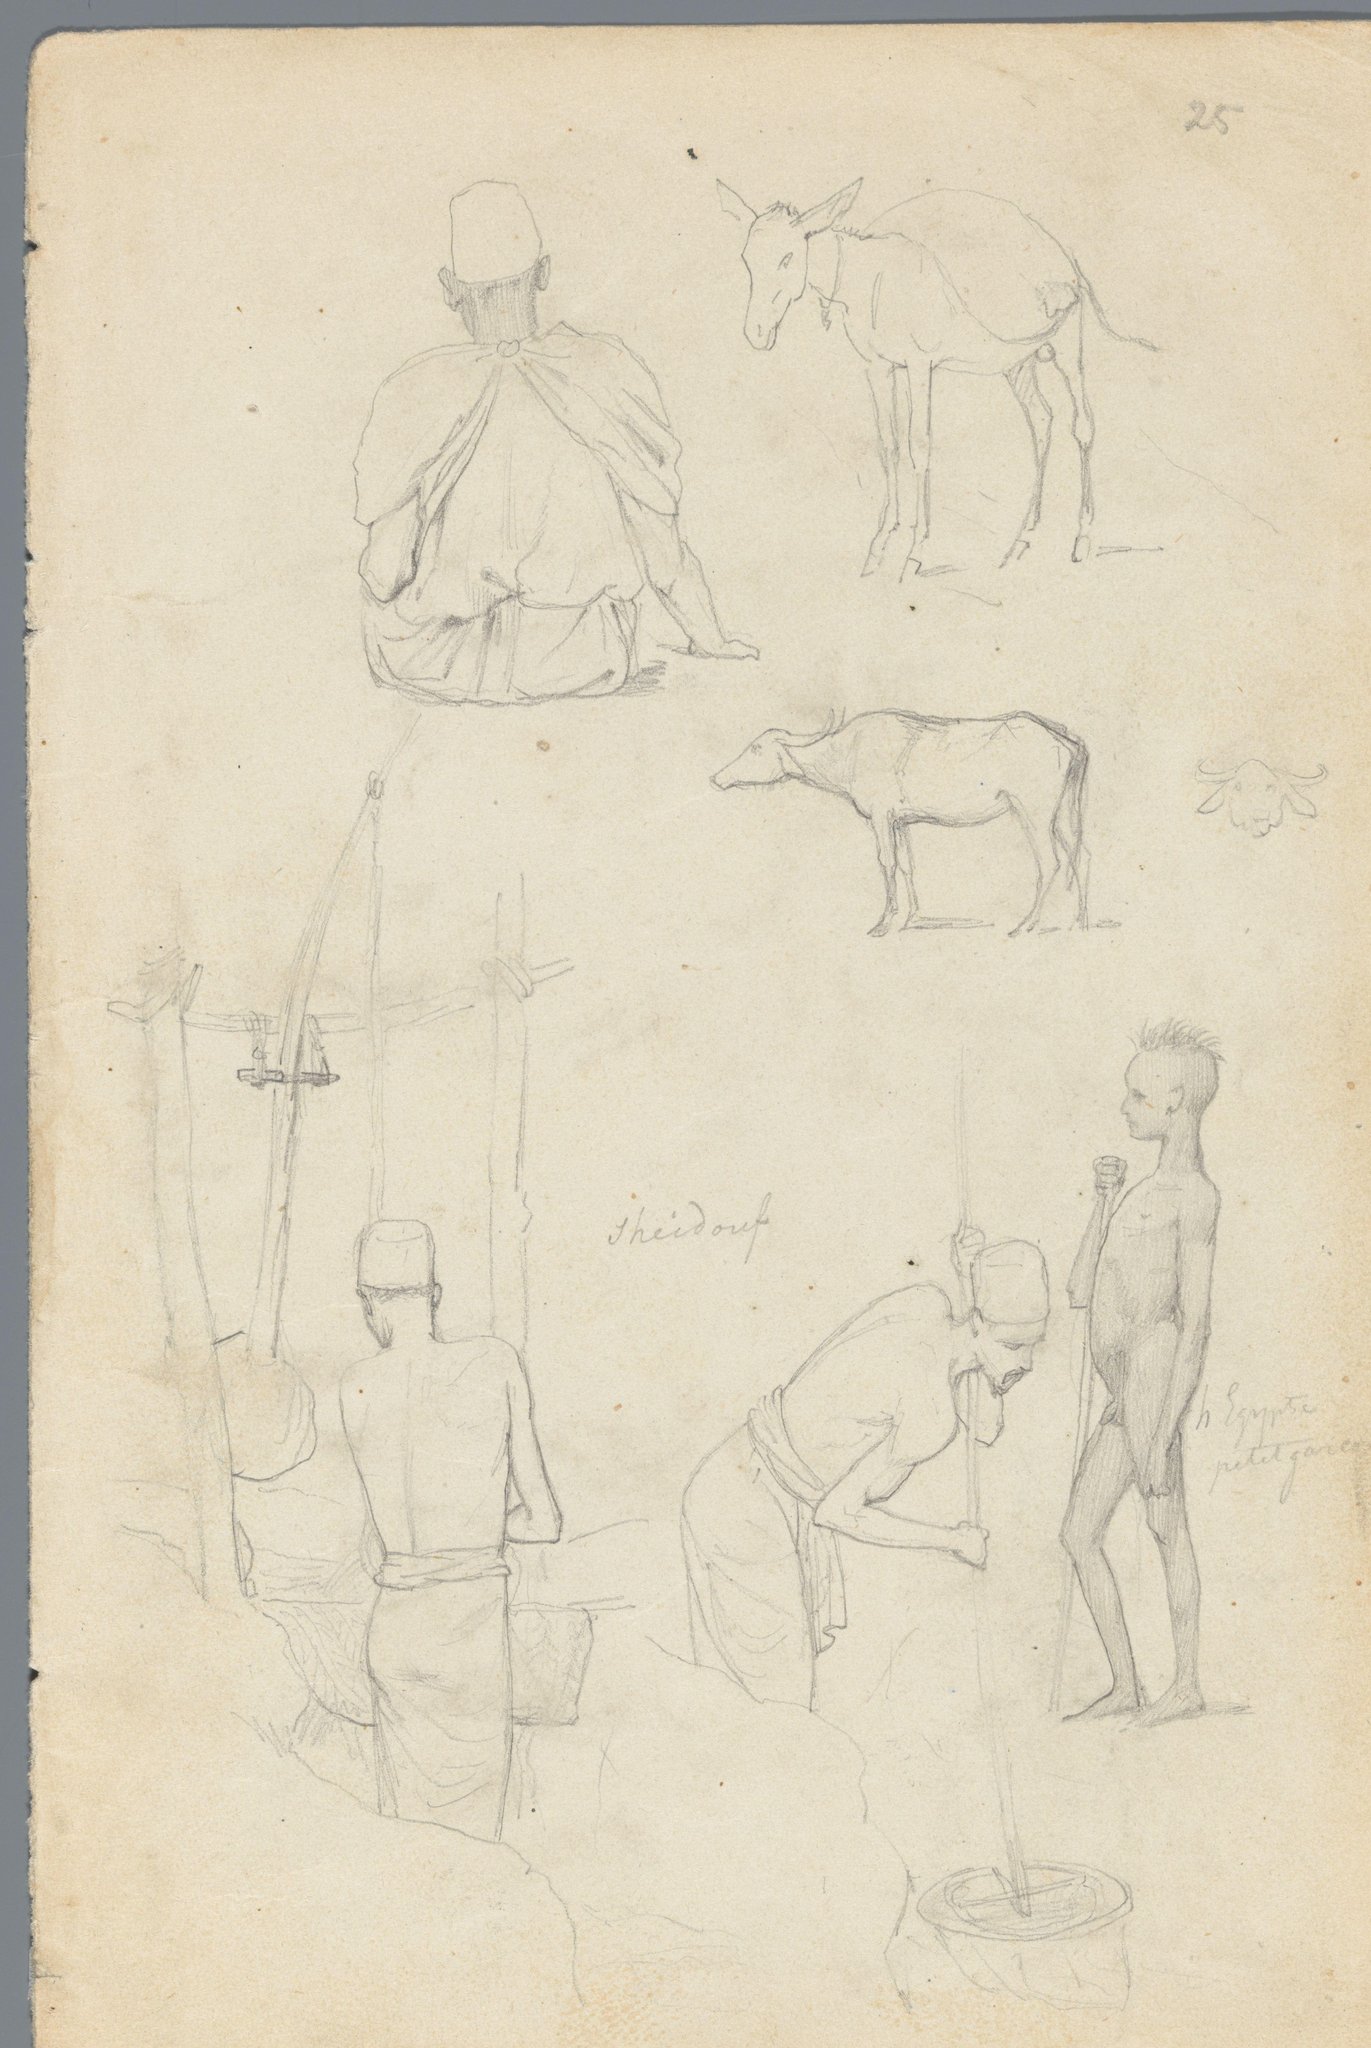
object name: sketchbook leaf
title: Vijf studies van Egyptenaren en dieren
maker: willem de famars testas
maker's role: draughtsman, painter, print maker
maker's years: 1834-1896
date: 1858-1859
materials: pencil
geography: egypt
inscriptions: inscription: ‘sheidouf’, inscription: ‘h Egypte / pekelgaren’, inscription: ‘25’